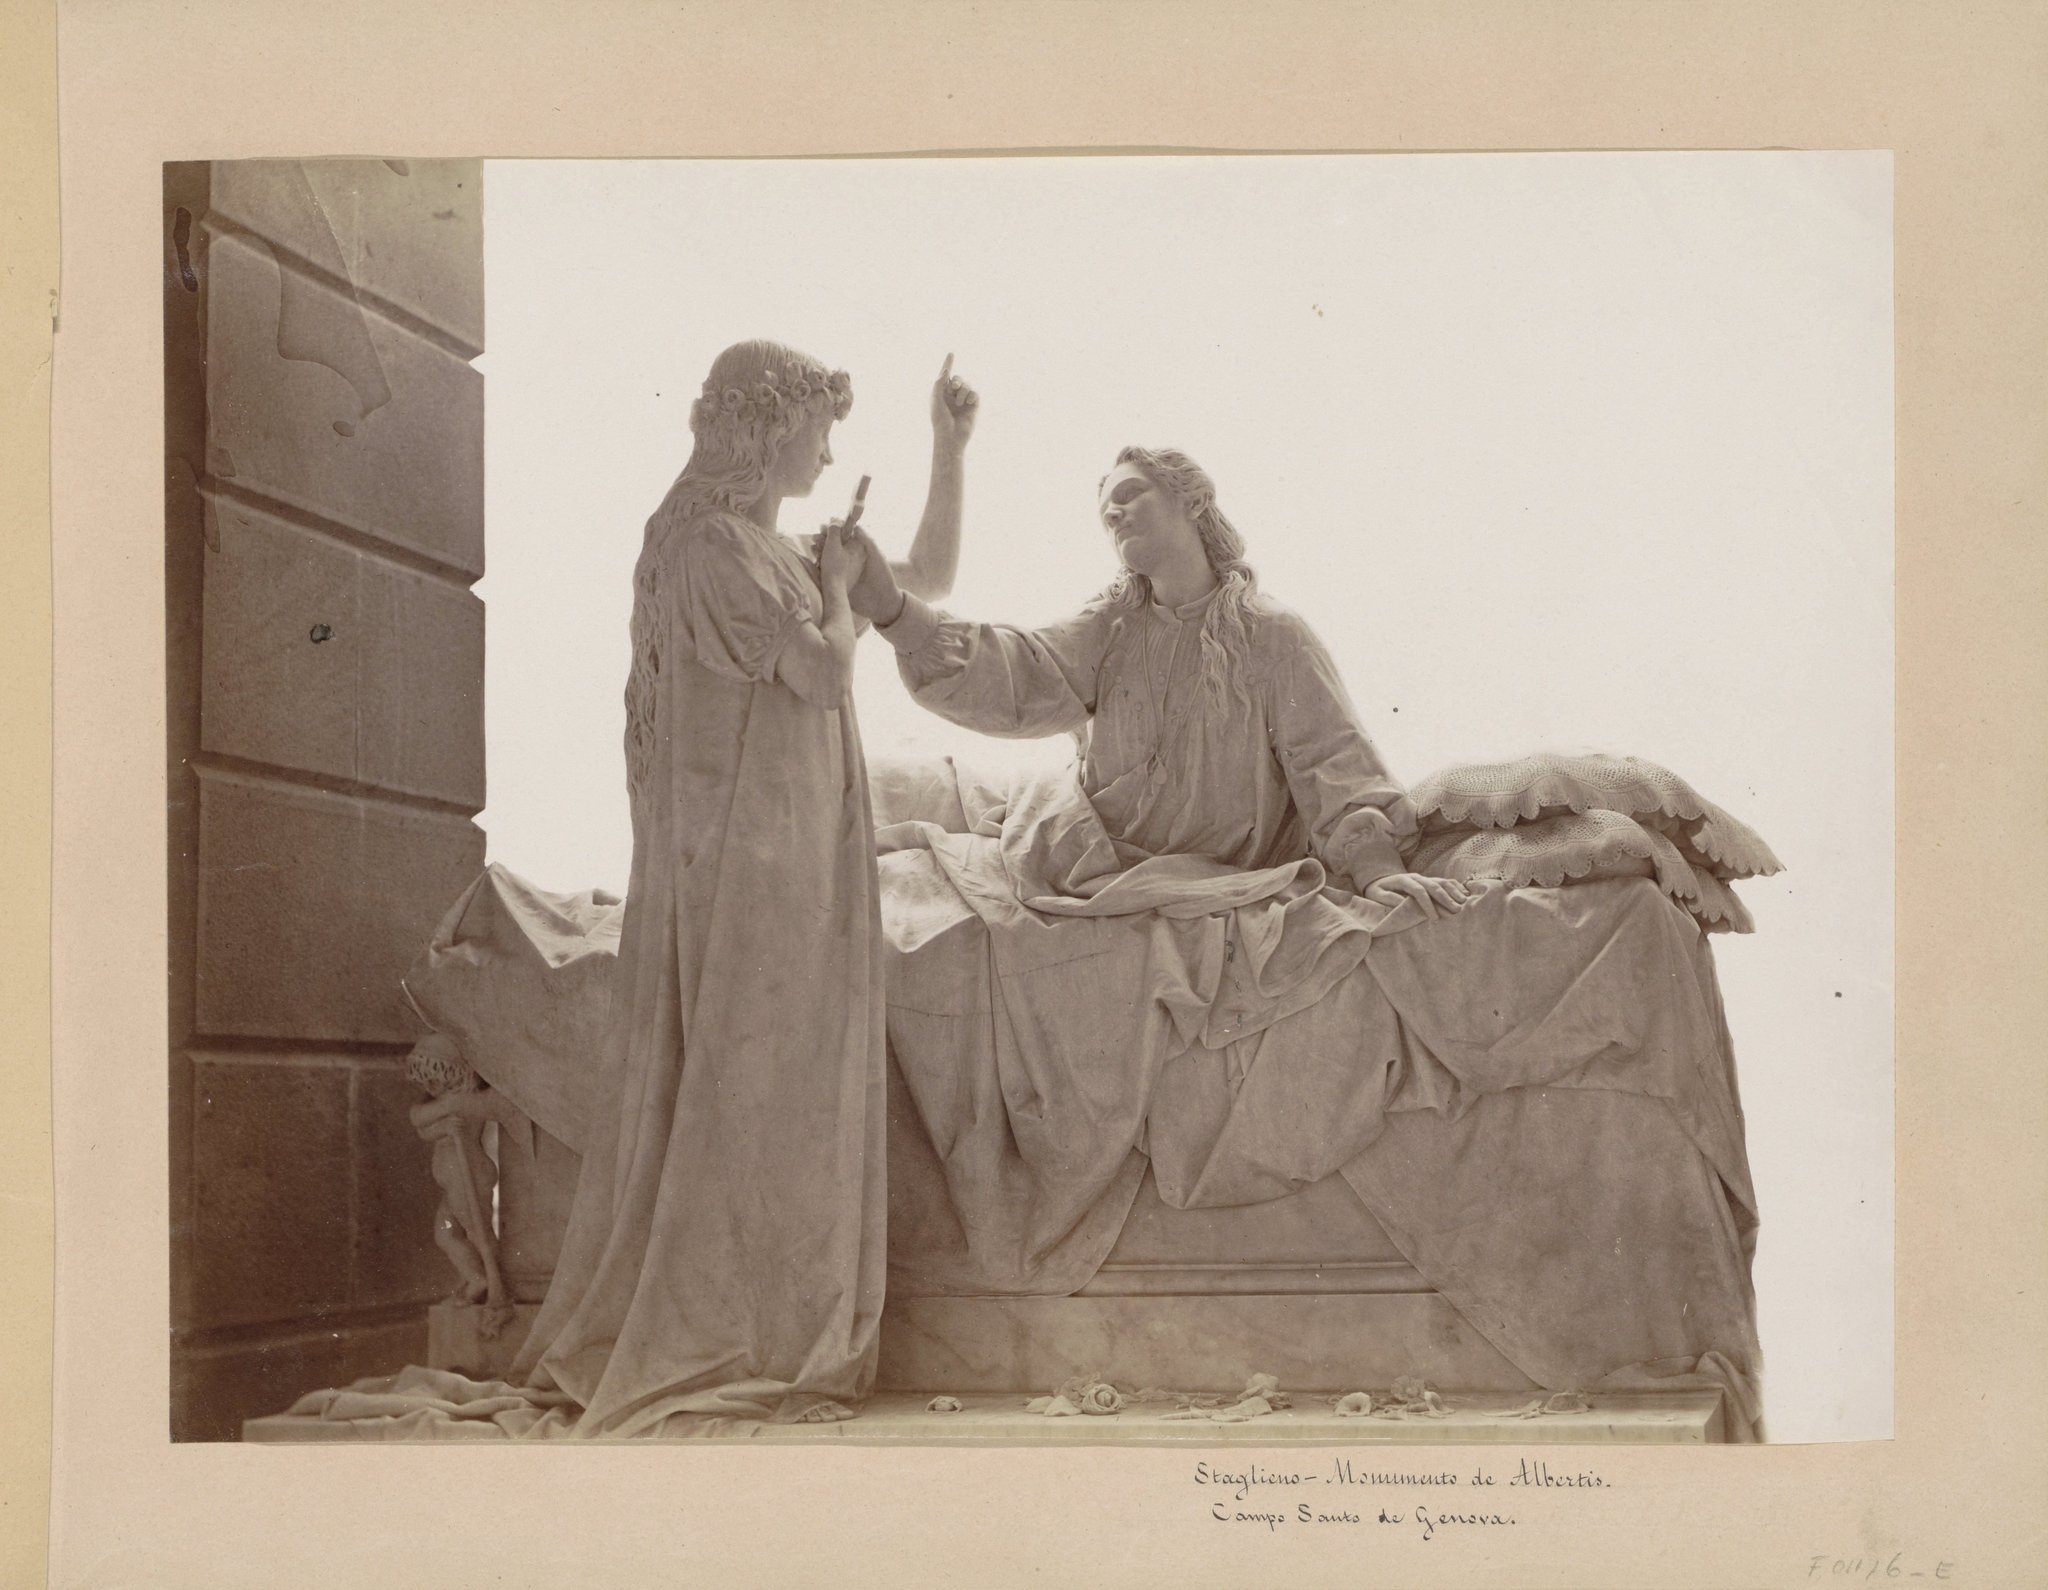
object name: photograph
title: Staglieno - Monumento de Albertis. Campo Santo de Genua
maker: Anonymous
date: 1850-1876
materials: photographic support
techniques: albumen print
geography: genoa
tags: piece of sculpture, reproduction of a piece of sculpture (+ sculpture), travelling; tourism, cemetery, park-like burying ground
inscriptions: check stamp: ‘[...]iappe[...]’, check stamp: ‘Genova’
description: Onderdeel van Reisalbum met foto's en tekeningen van Manuel Mayo 1876.